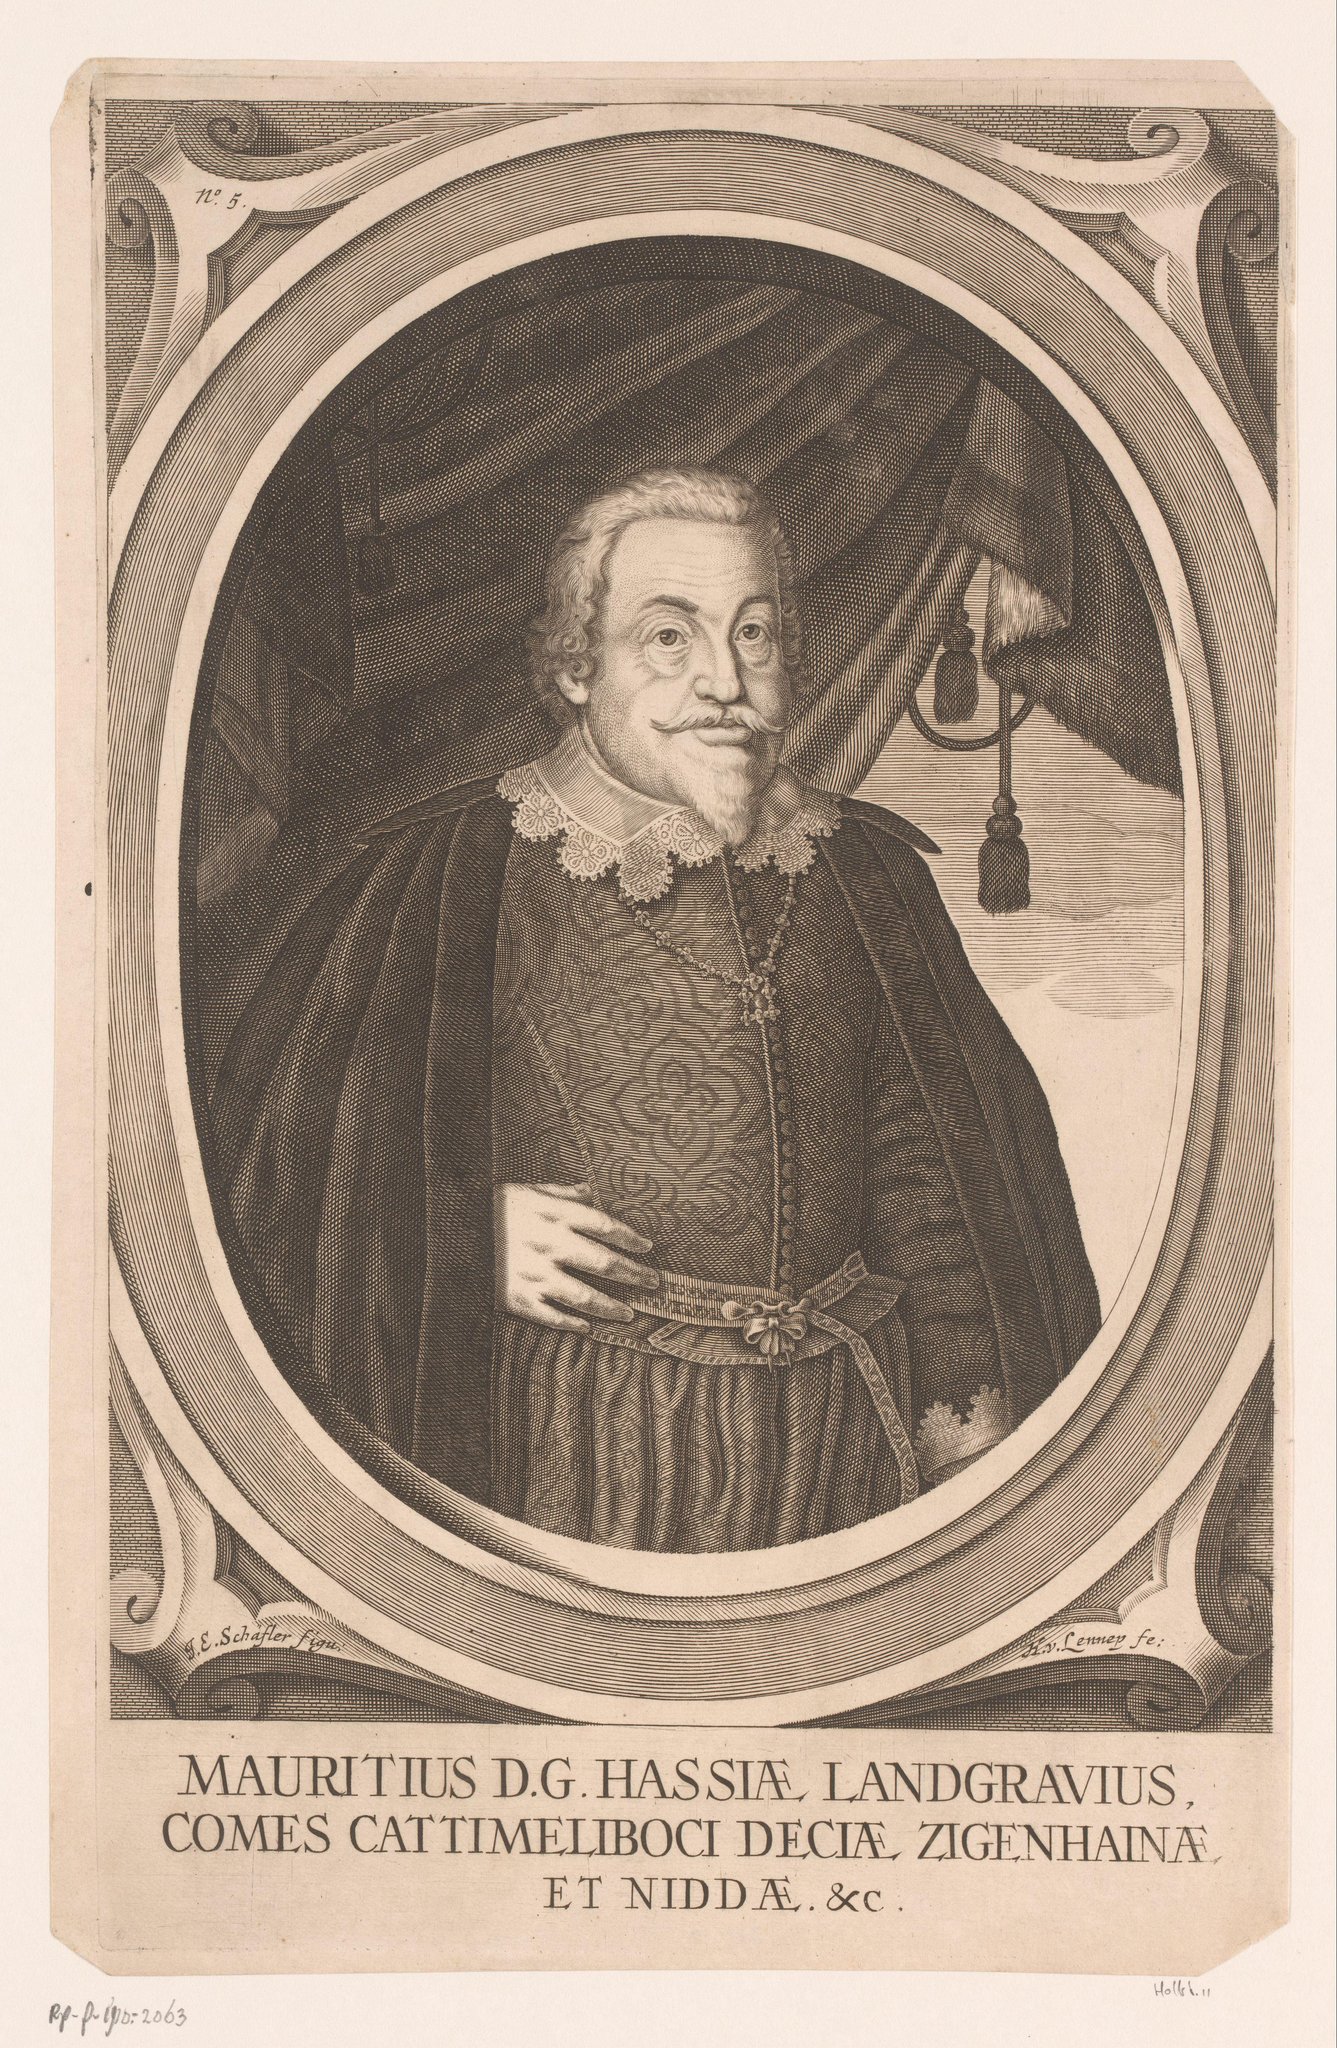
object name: print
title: Portret van Maurits van Hessen-Kassel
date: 1611-1710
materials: paper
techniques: engraving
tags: historical persons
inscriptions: collector's mark: Lugt 2228